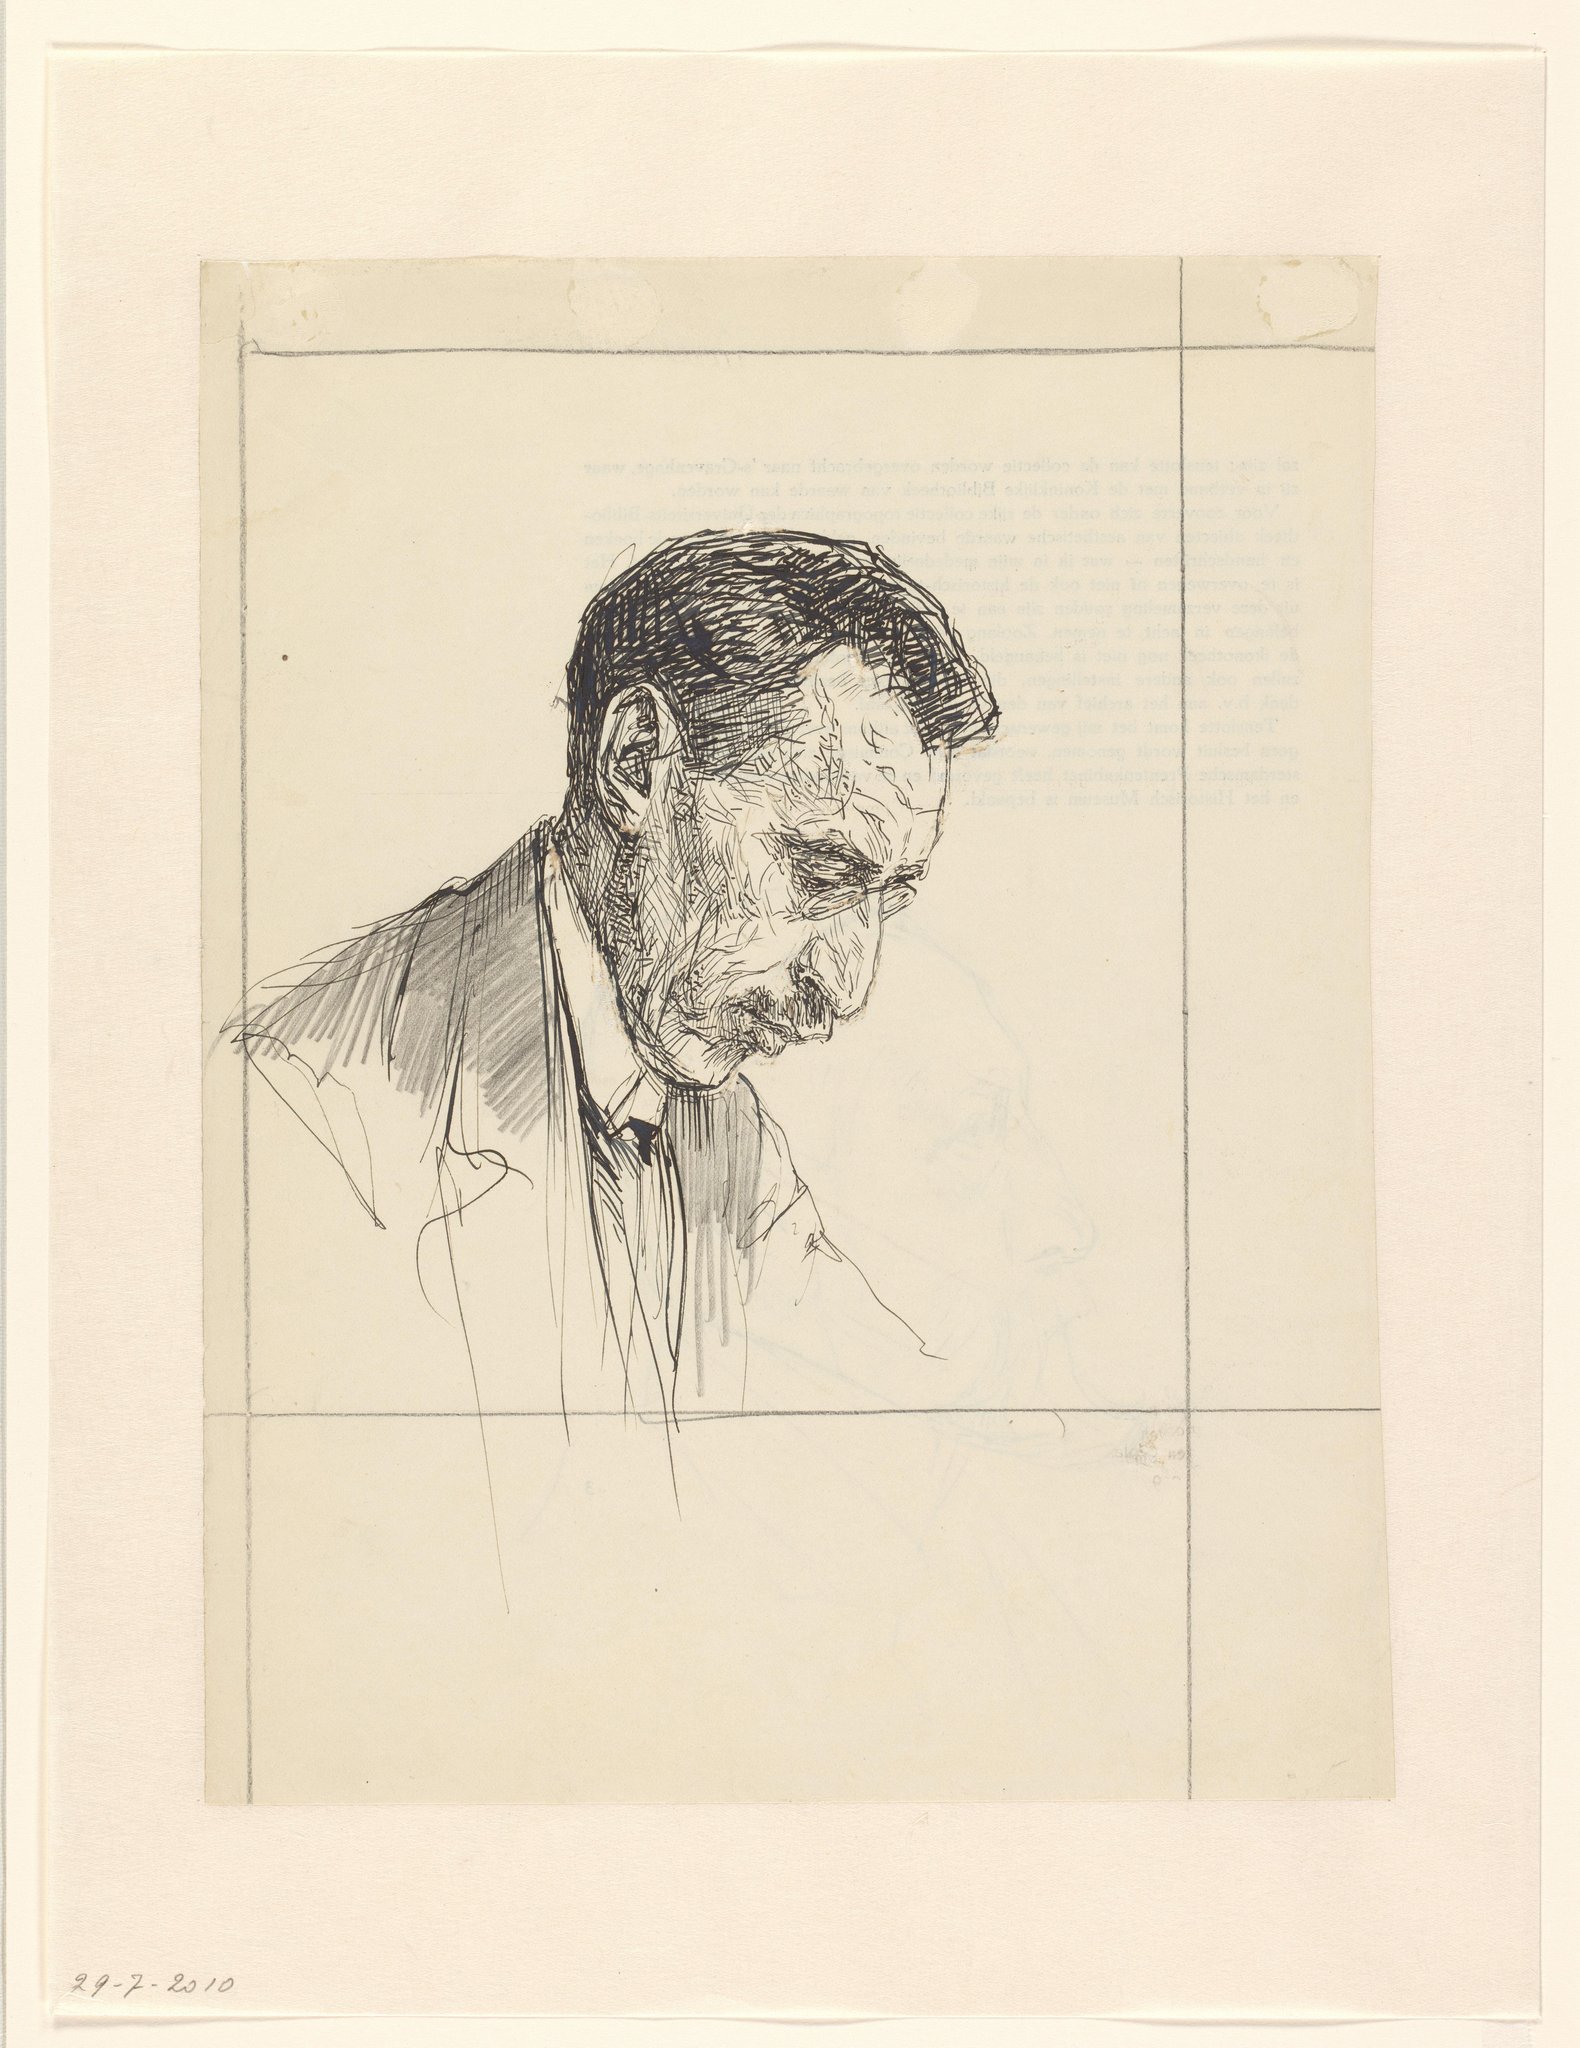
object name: drawing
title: Portret van P. Visser, profiel naar rechts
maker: jan veth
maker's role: designer, draughtsman, painter, print maker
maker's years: 1864-1925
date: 1874-1925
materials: ink, paper, pencil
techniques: pen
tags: piet visser, historical persons